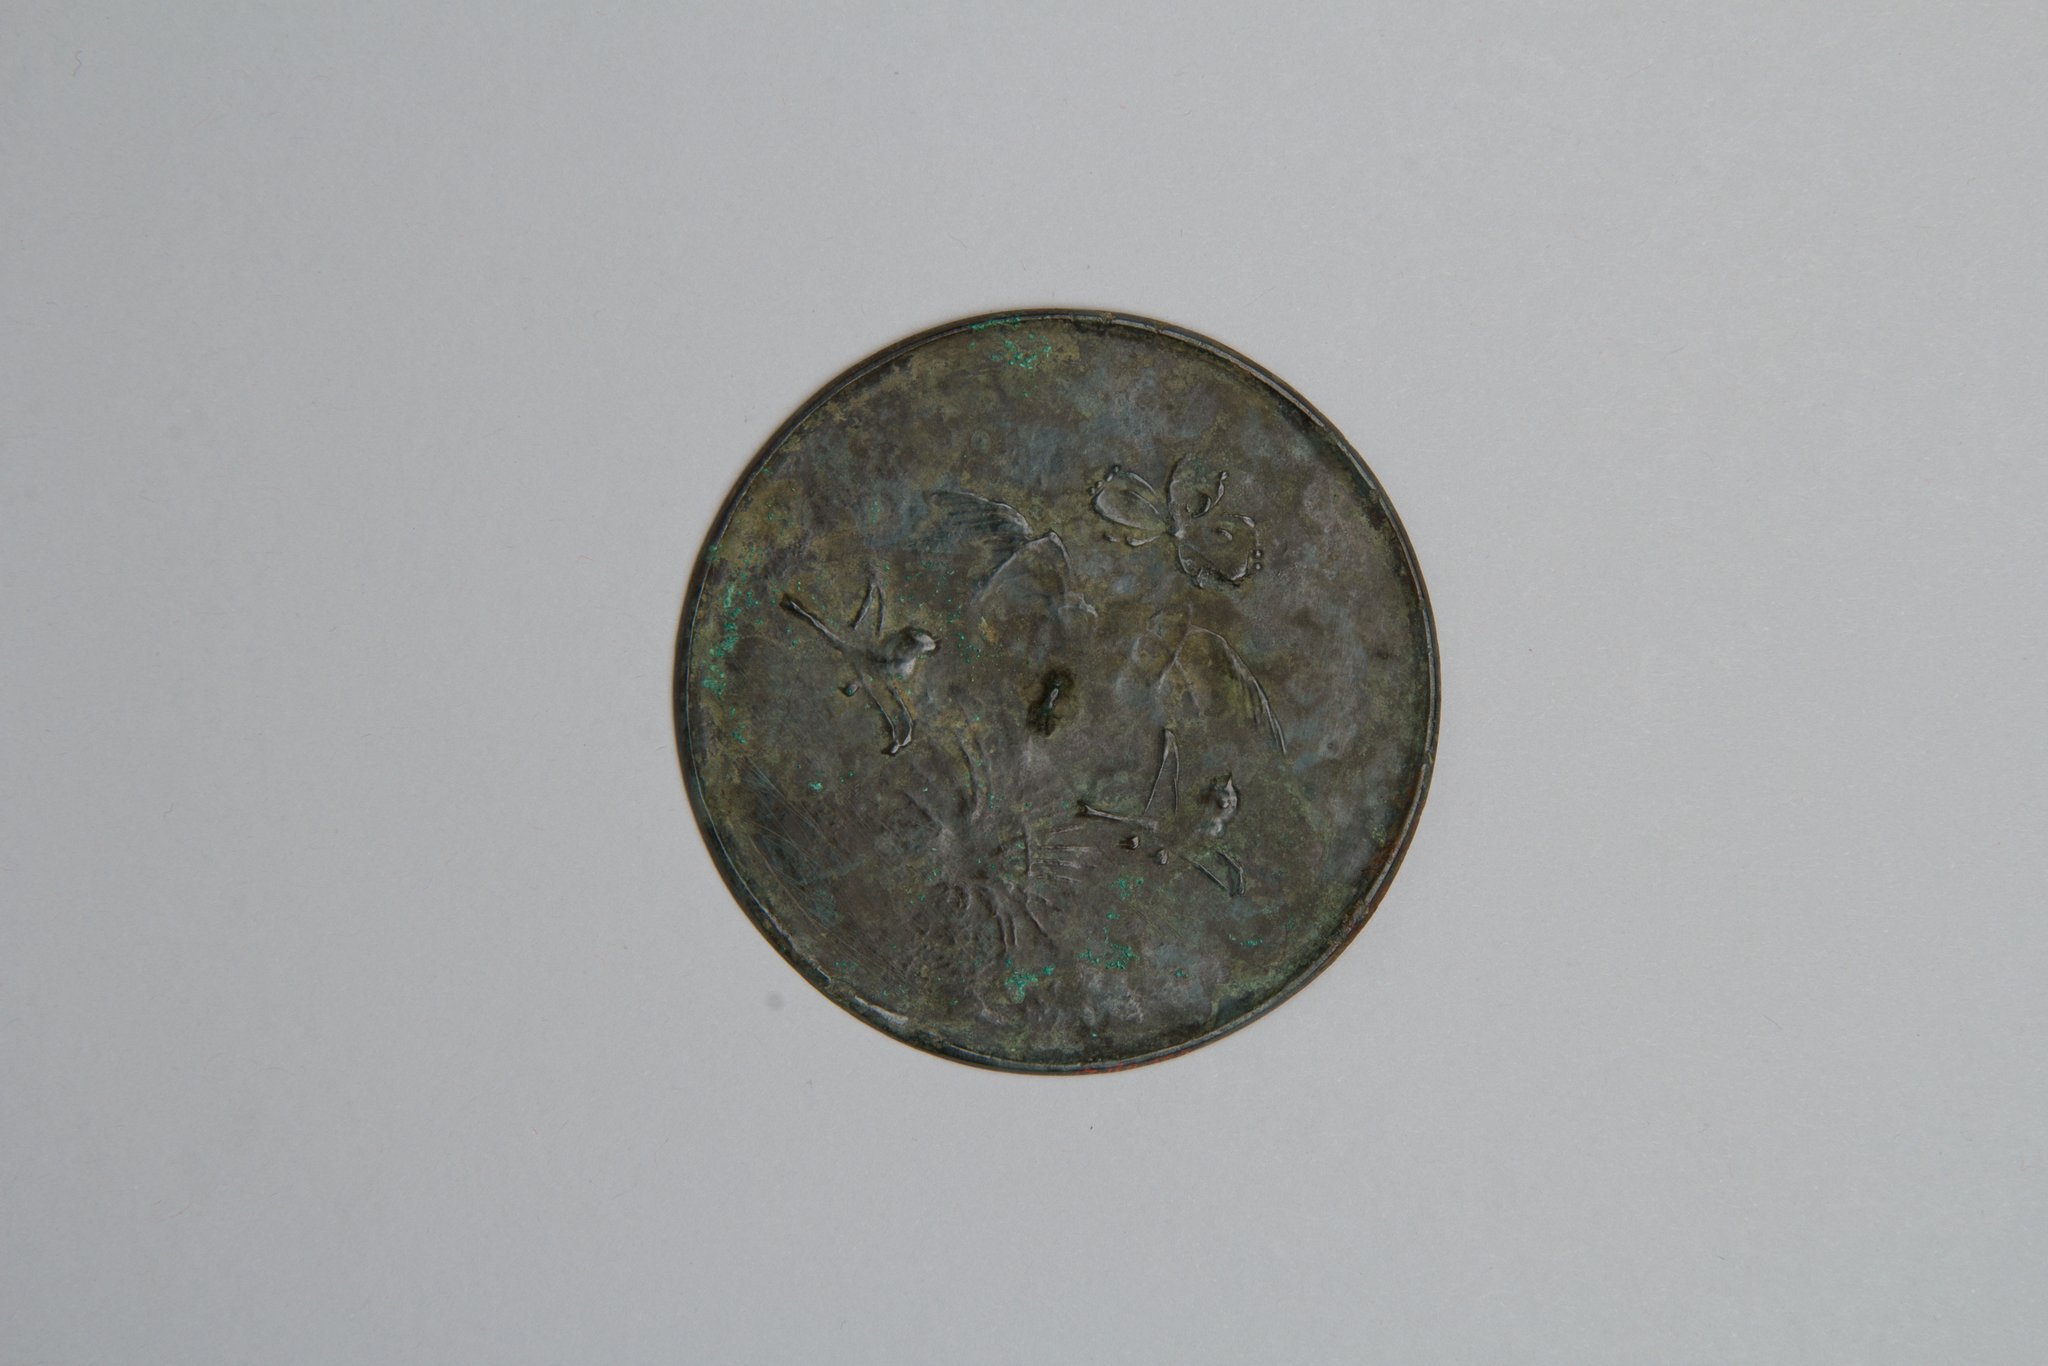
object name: mirror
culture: japanese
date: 794-1185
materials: bronze